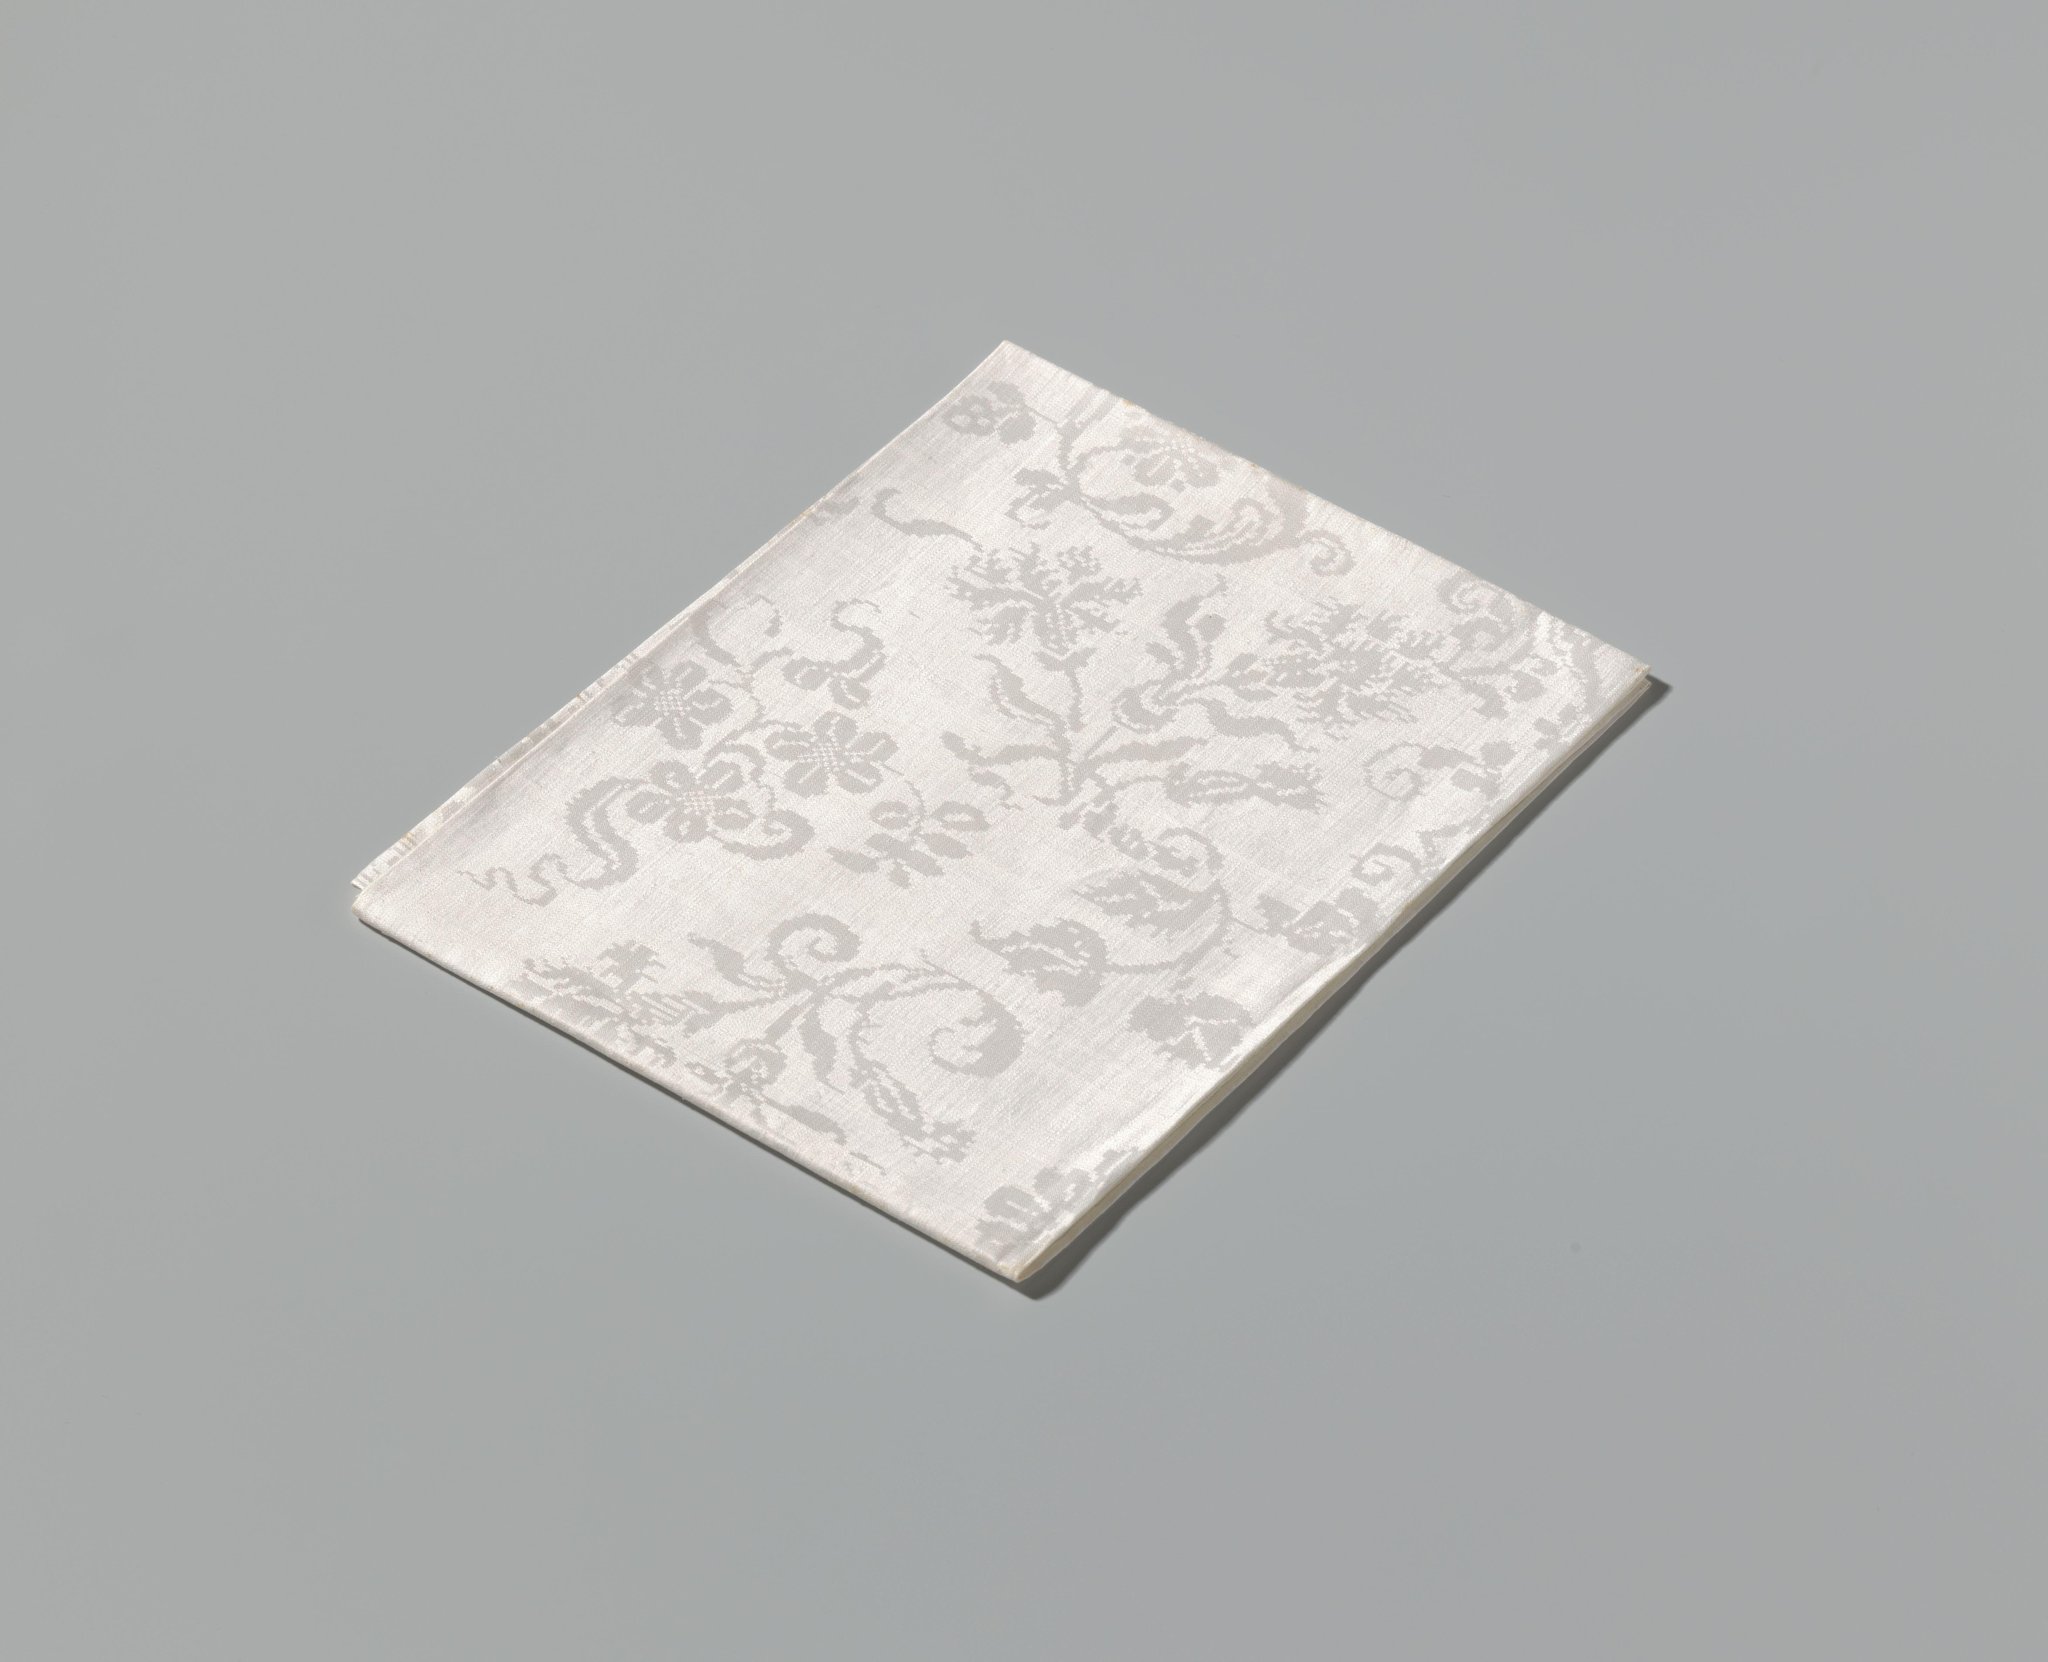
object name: napkin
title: Gestrooide bloemtakken. Merk: SH 48 WH 2oonl..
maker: Anonymous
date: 1690-1699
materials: linen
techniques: damask, weave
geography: flanders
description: Servet van wit linnen met een patroon van gestrooide bloemtakken, merk SH en 48 WH 2oonl.